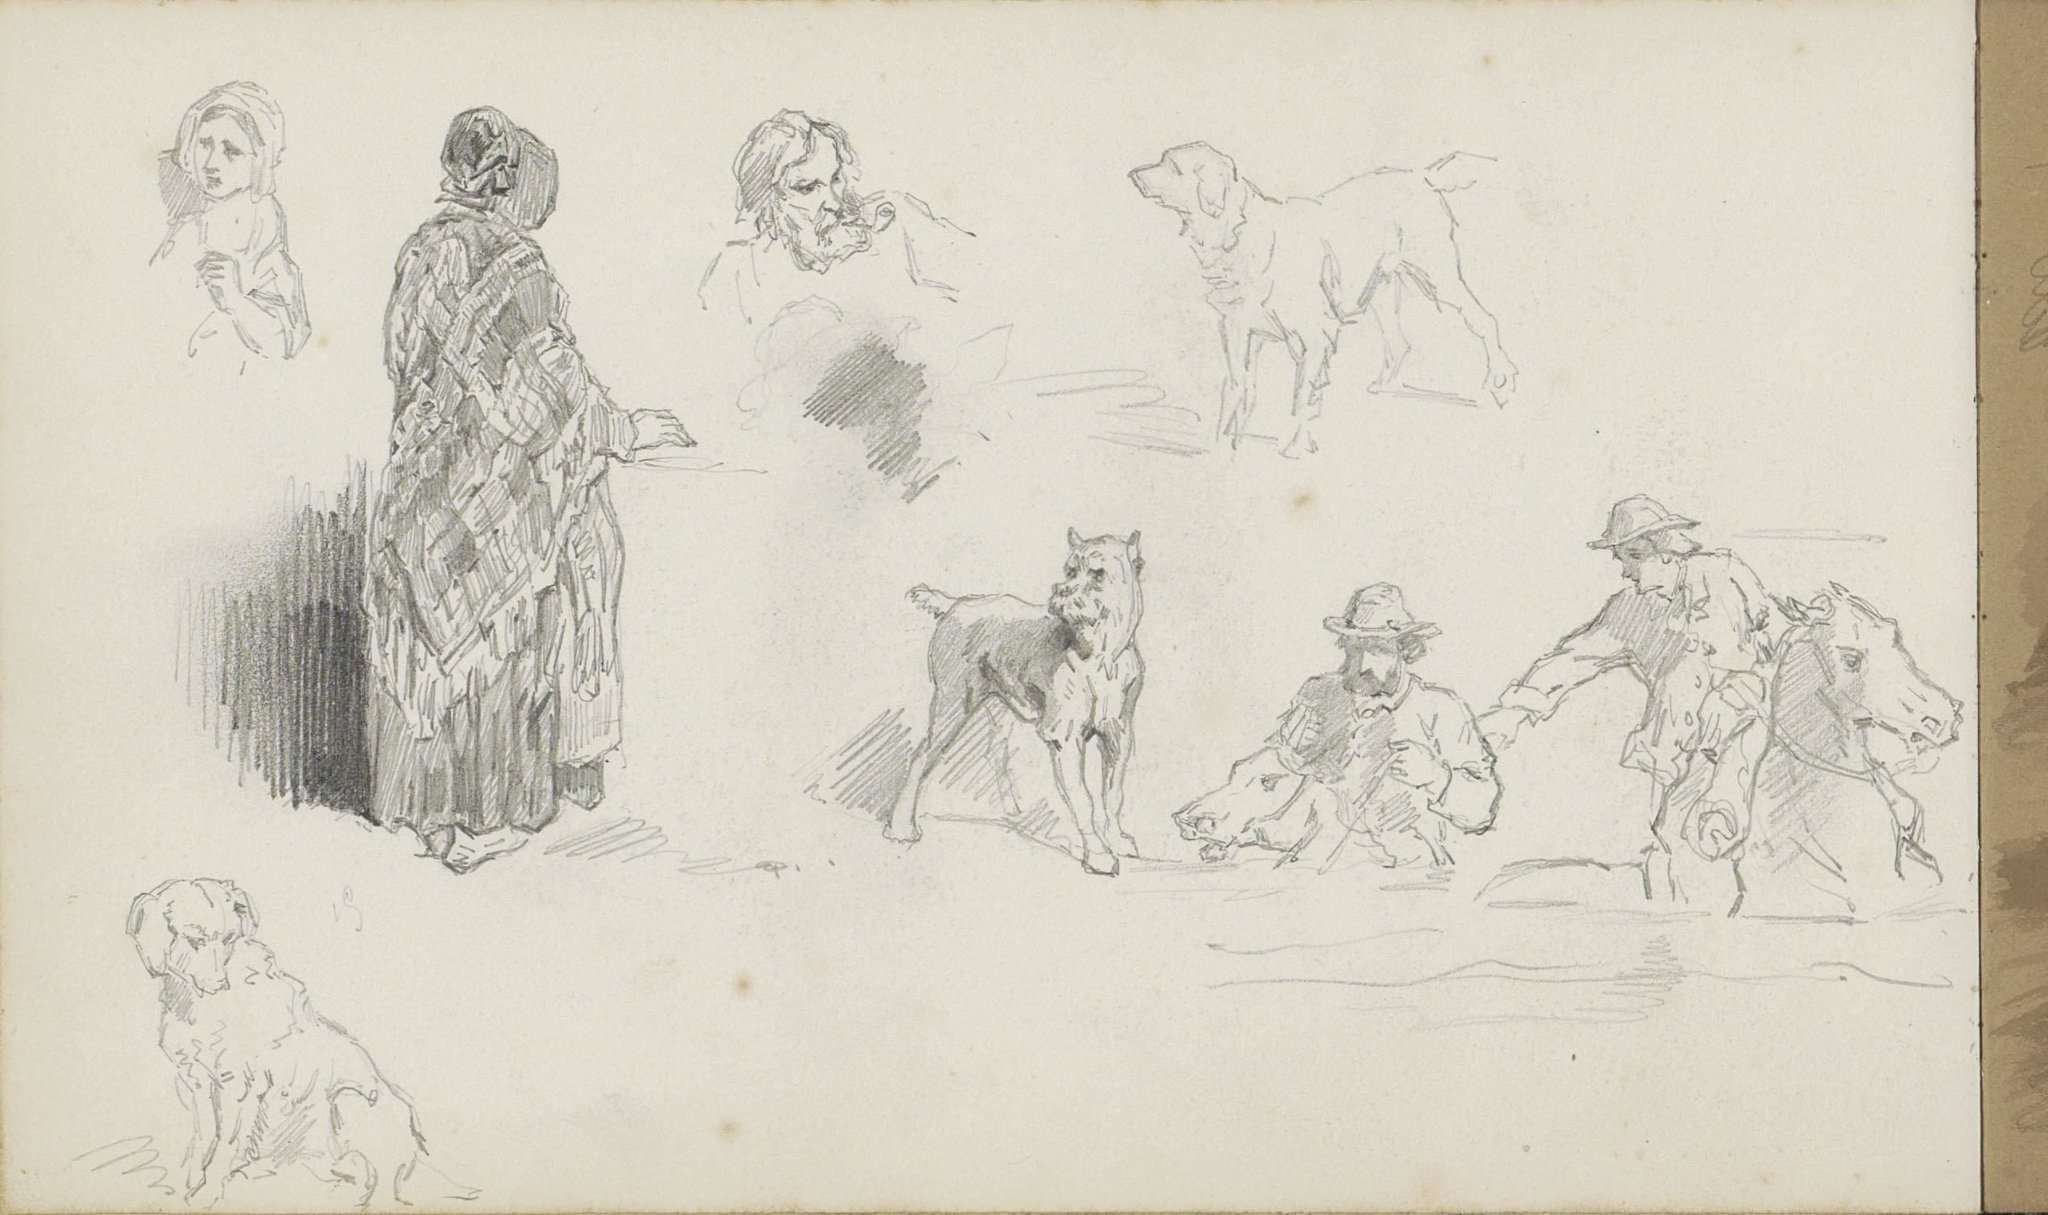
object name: sketchbook leaf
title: Studieblad met honden, ruiters en figuren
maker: charles rochussen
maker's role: draughtsman, painter, print maker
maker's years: 1814-1894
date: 1840-1860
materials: paper, pencil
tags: riding a horse, ass, or mule; rider, horseman, anatomy (non-medical), dog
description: Blad 28 verso uit een schetsboek met 38 bladen.